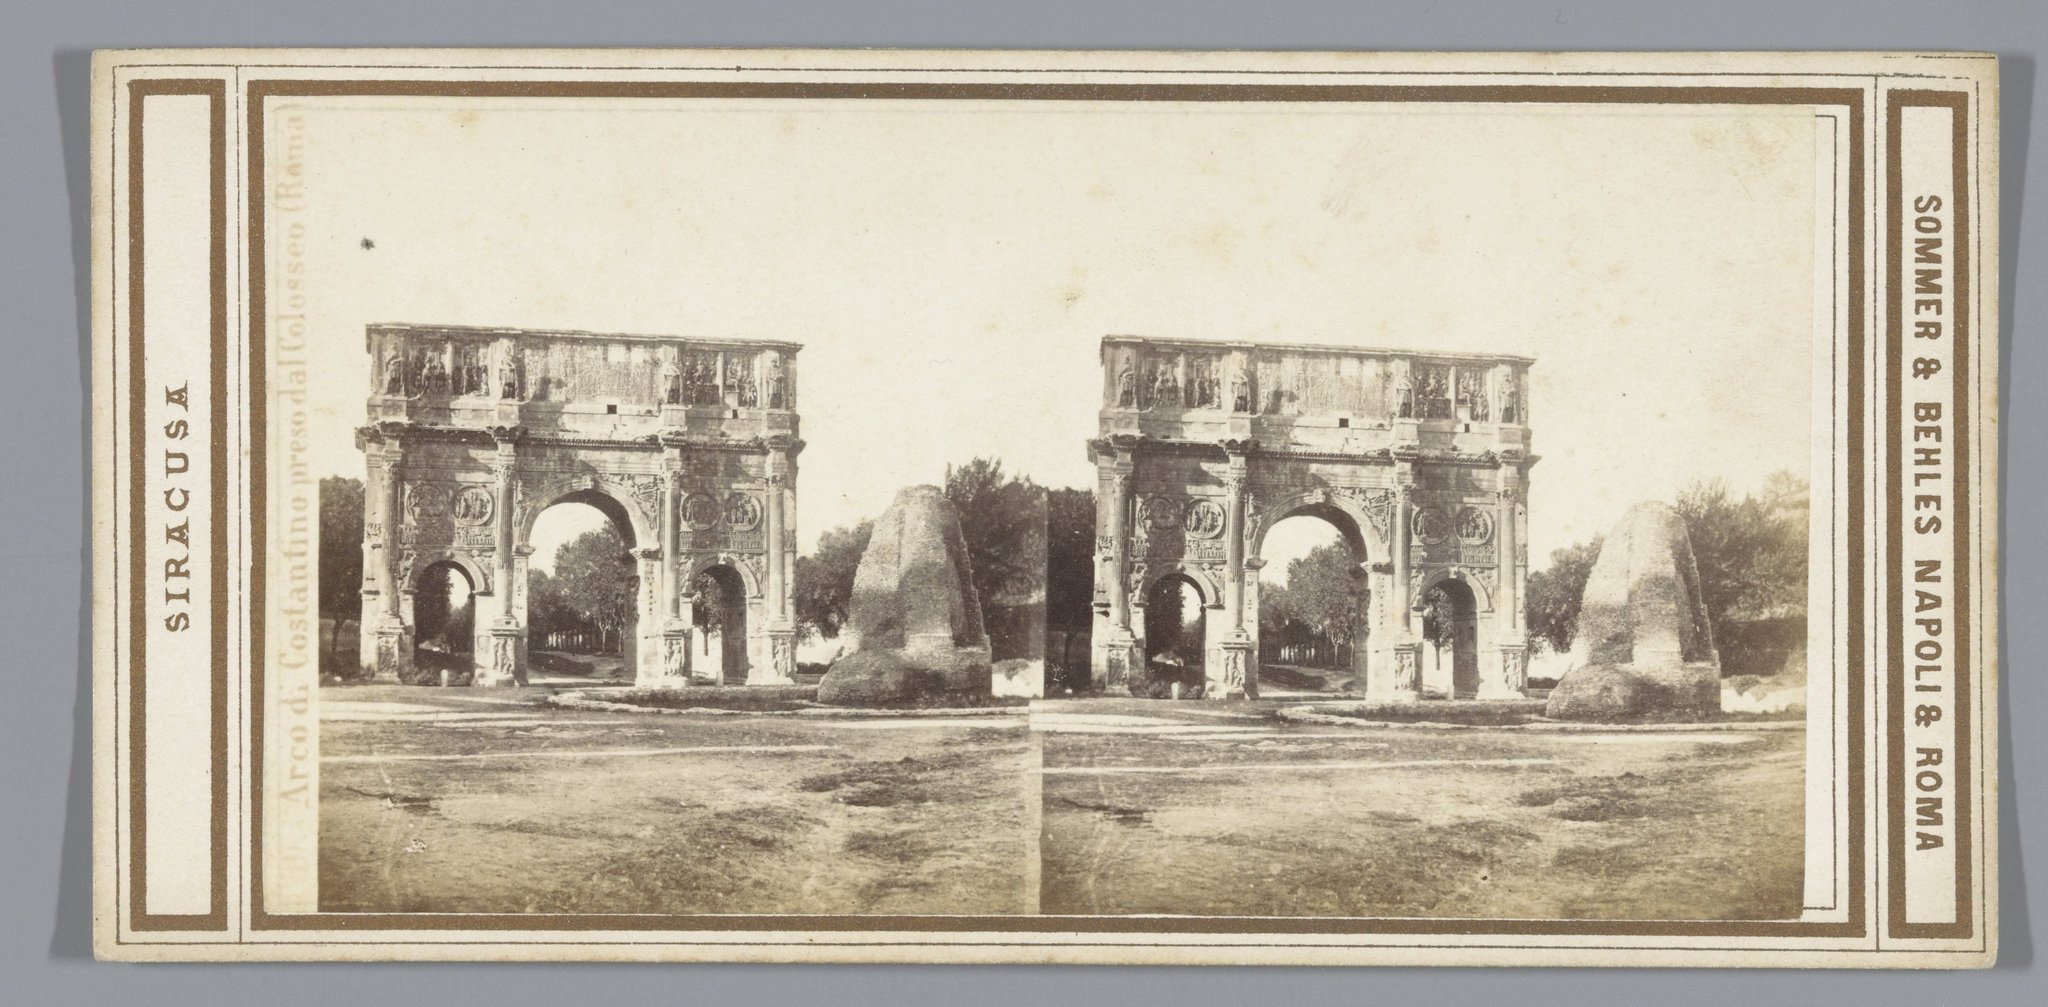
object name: stereograph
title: Arco di Costantino preso dal Colosseo (Roma)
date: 1860-1880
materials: cardboard, photographic support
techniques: albumen print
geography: rome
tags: triumphal arch, arch of constantine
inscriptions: number